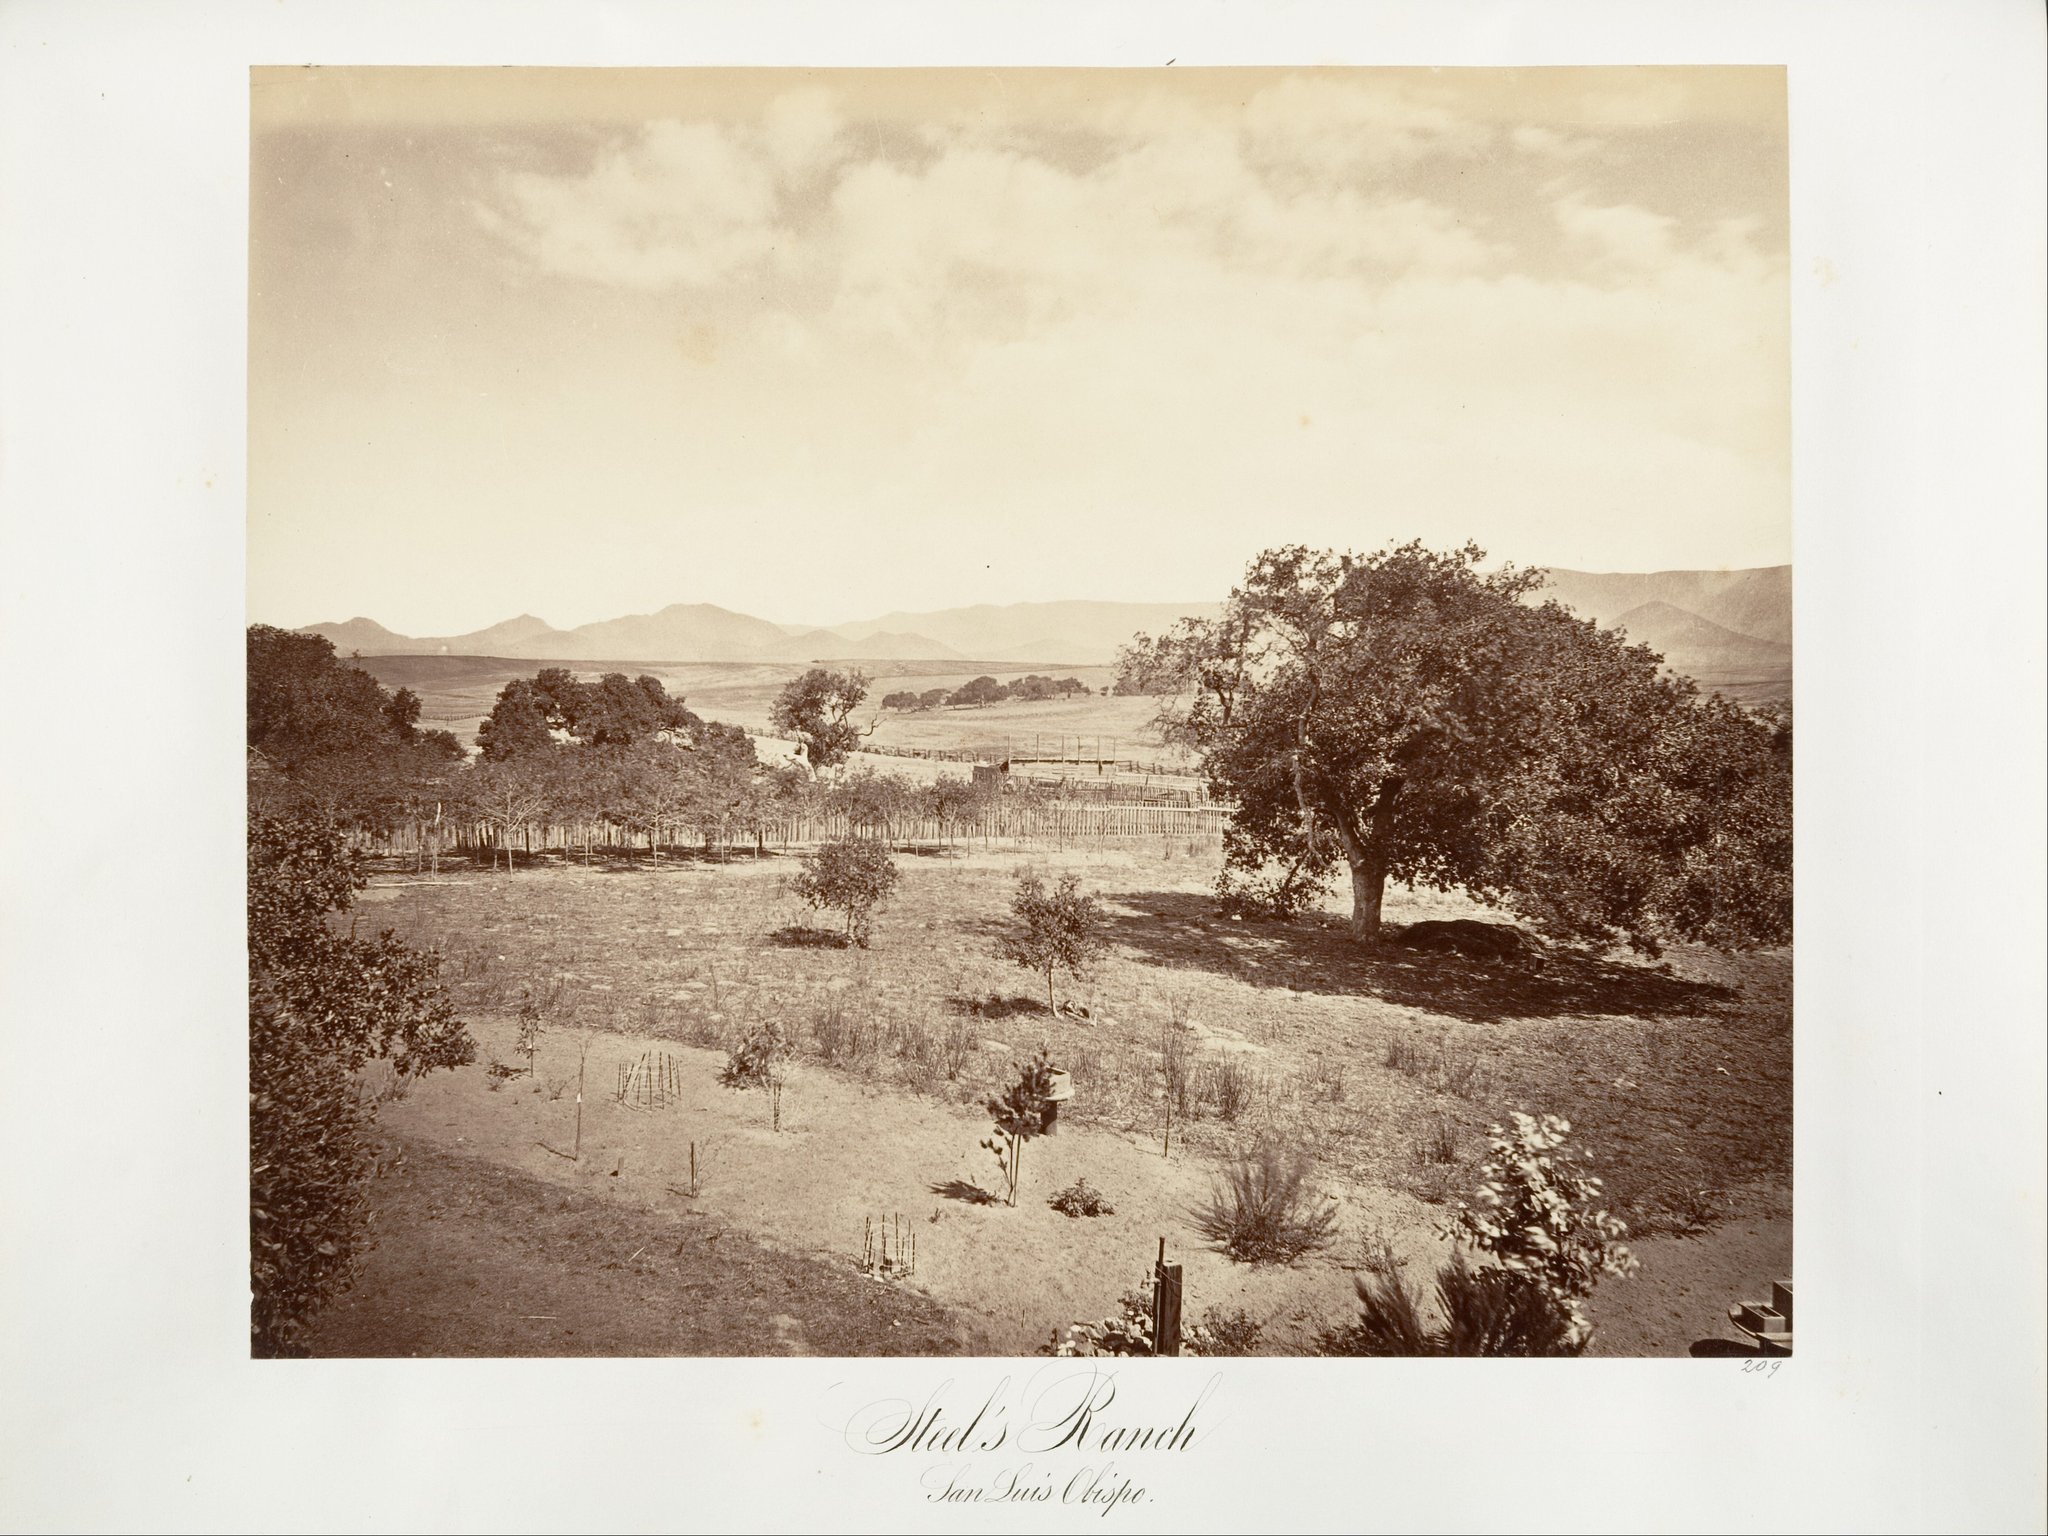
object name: photograph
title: Steel's Ranch, San Luis Obispo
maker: carleton e. watkins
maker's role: artist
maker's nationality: american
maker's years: 1829-1916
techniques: albumen silver print, glass negative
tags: landscapes